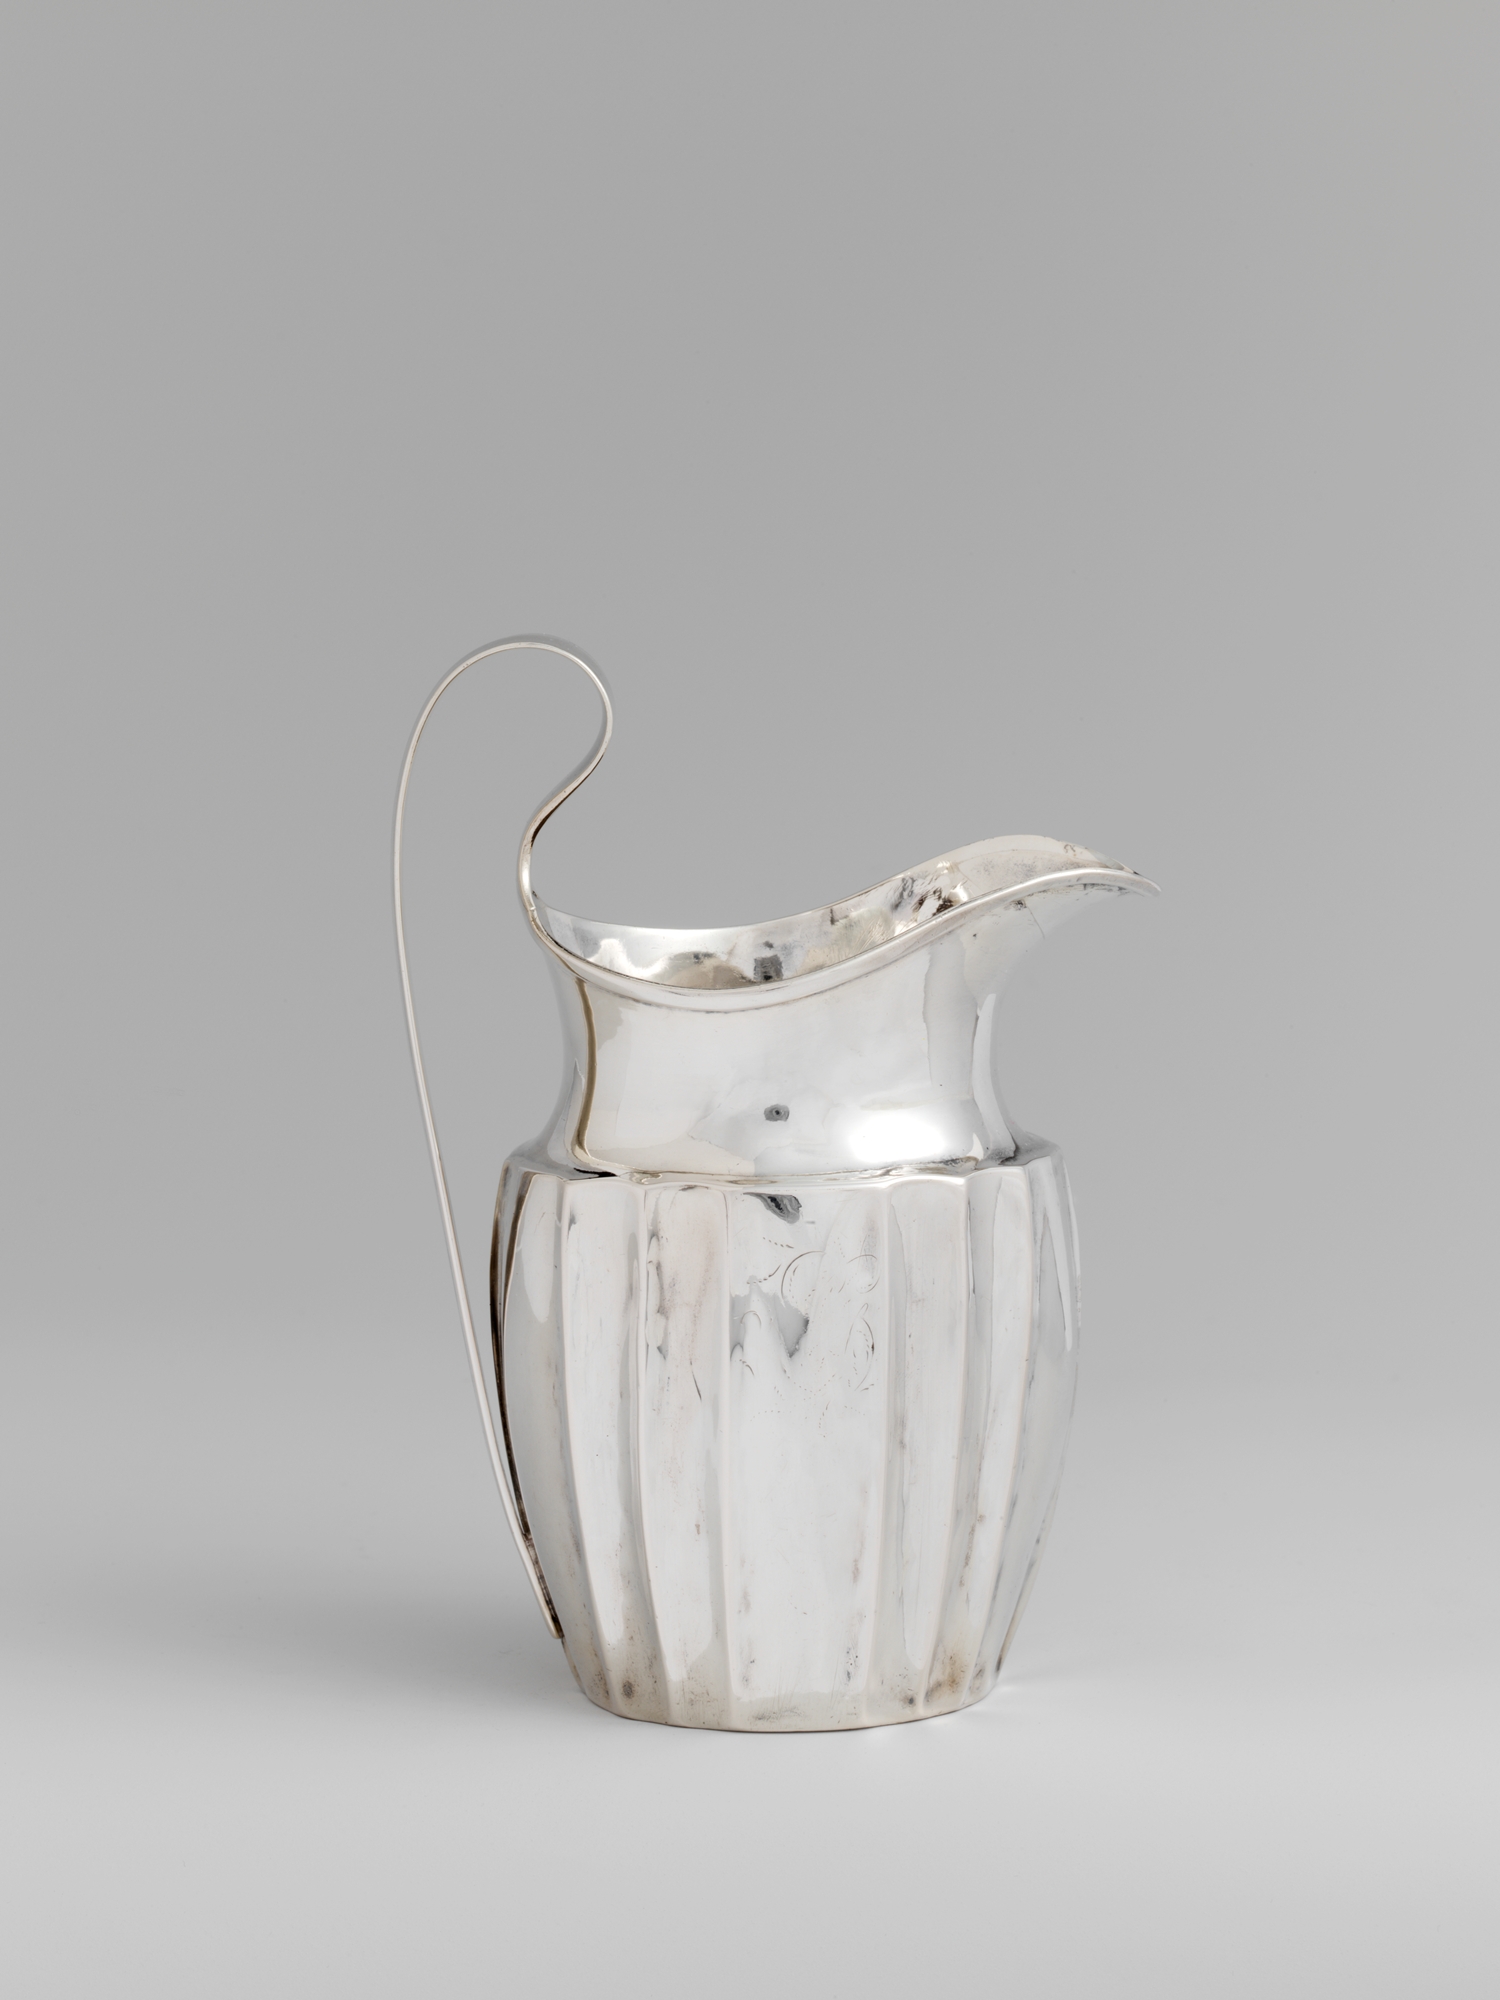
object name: cream pot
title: Creamer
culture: american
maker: moore and ferguson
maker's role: maker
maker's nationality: american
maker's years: 1798-1804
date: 1800-1830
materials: silver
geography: united states